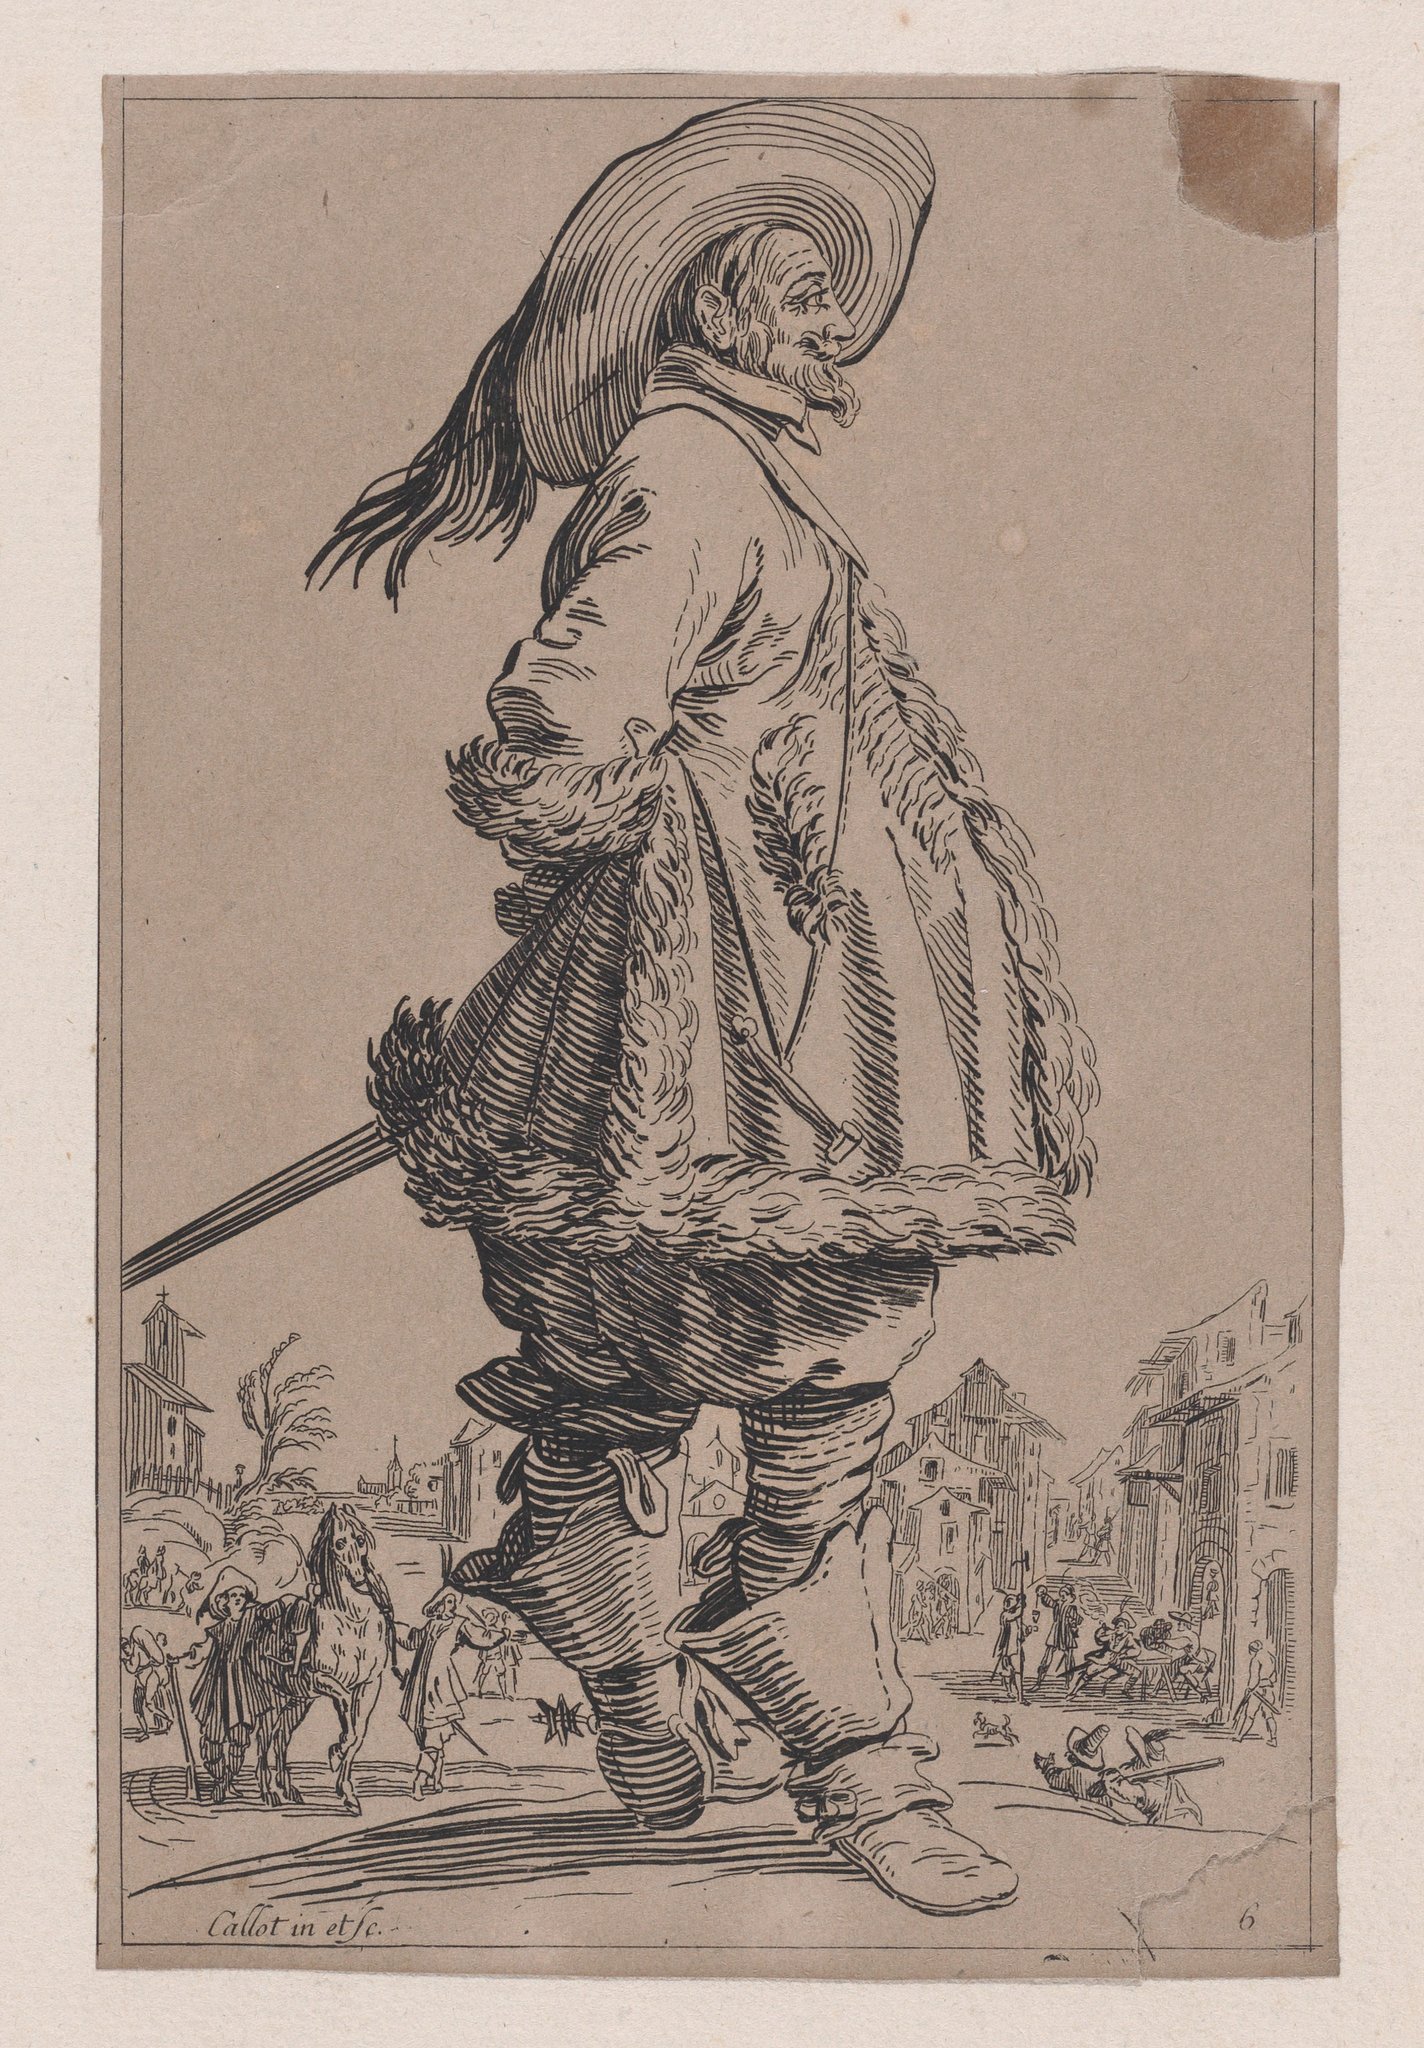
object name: print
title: Copy of Le Gentilhomme au Manteau Bordé de Fourrures Tenant ses Mains Derrière le Dos (The Gentleman with a Fur-Lined Mantle Holding His Hands Behind his Back), from "La Noblesse" (The Nobility)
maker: Anonymous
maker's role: artist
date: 1601-1700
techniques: etching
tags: men